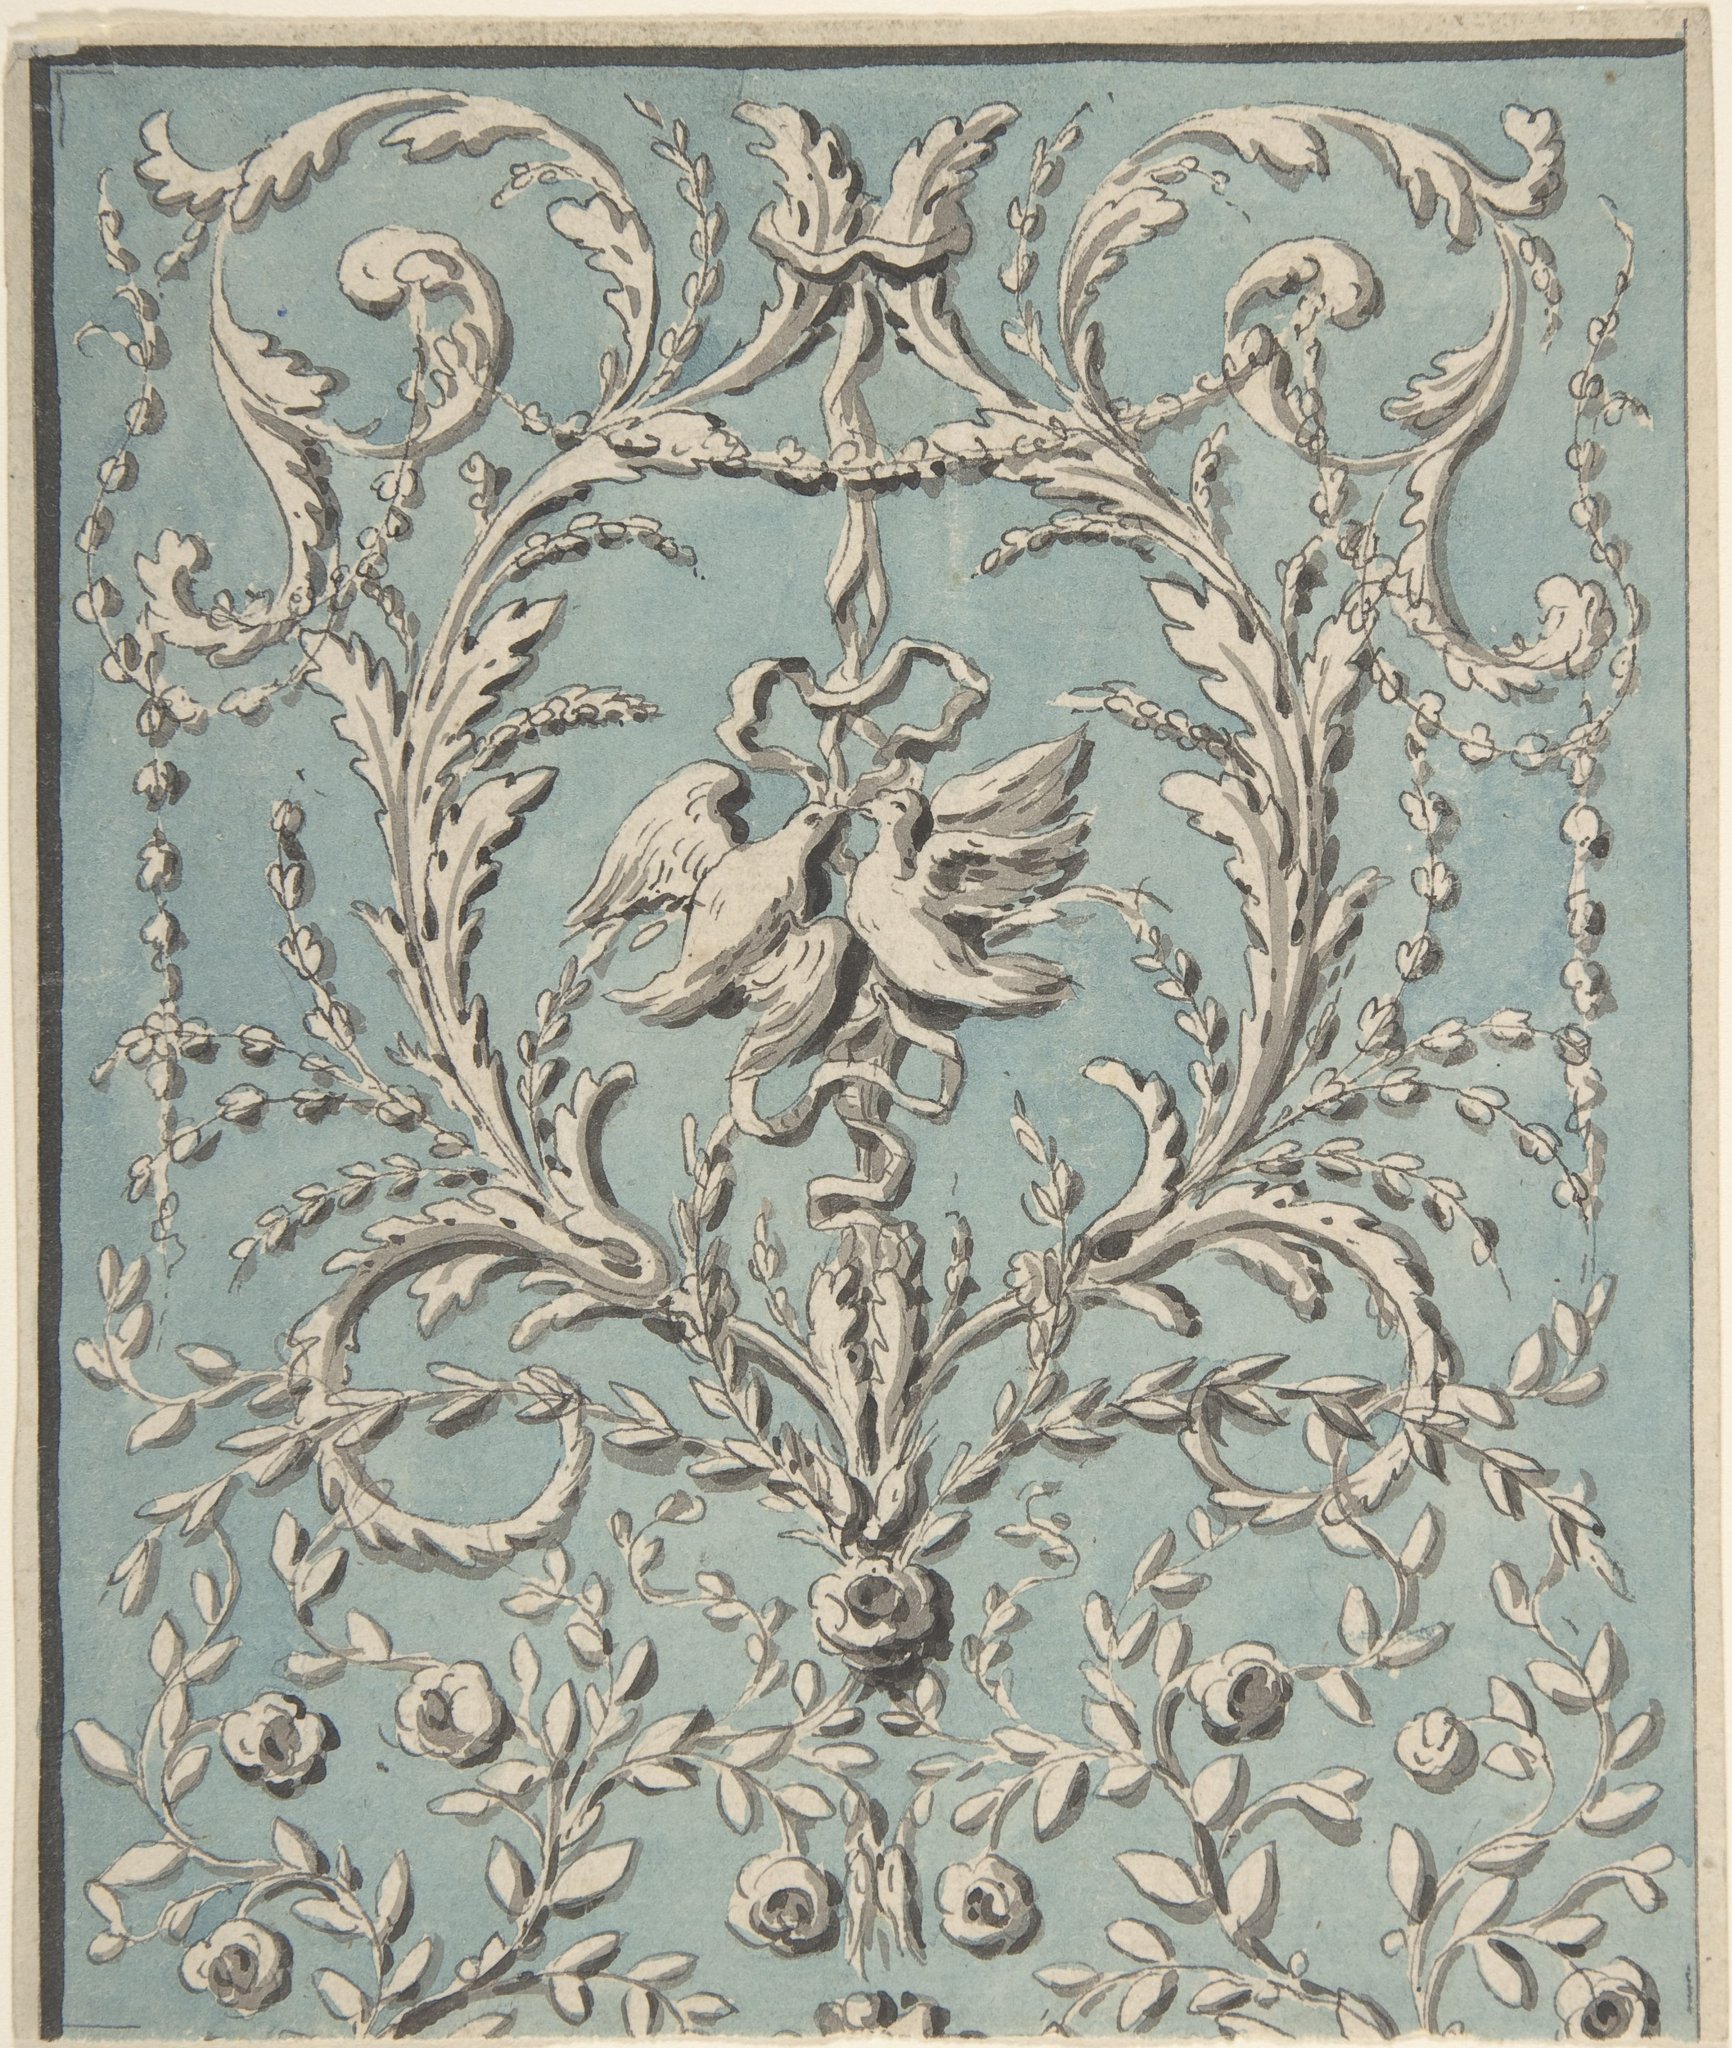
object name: drawing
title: Design for Upright Decorative Panels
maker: anonymous, french, 18th century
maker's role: artist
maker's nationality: french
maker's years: 1700-1800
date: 1701-1800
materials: ink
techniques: brush, cutting, pen, wash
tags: birds,flowers